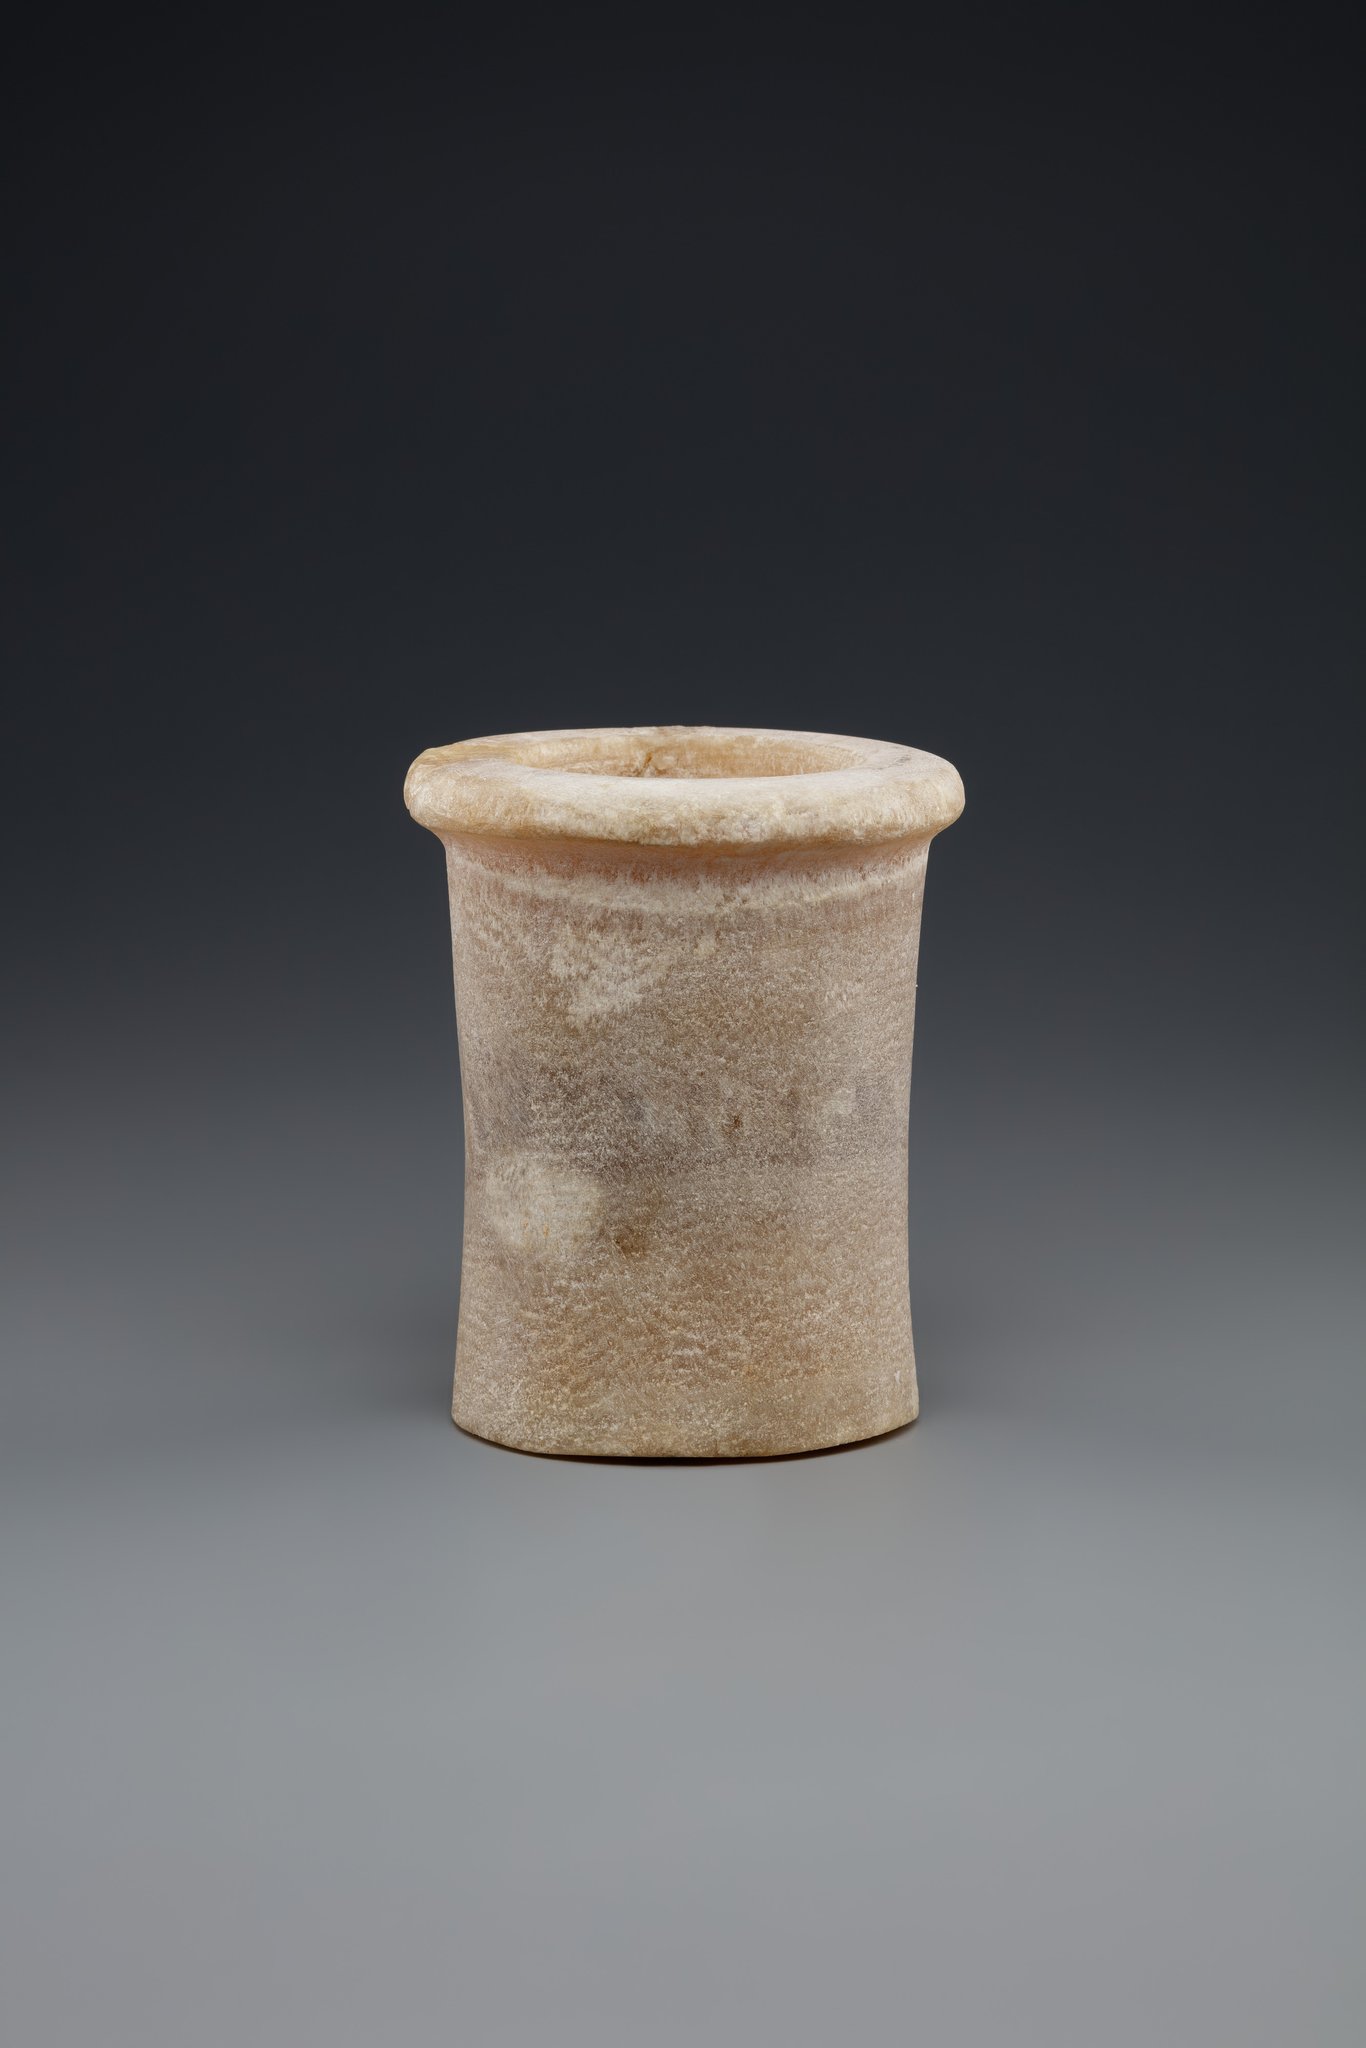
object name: jar, cylindrical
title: Cylinder jar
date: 3100-2649 BCE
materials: stone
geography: egypt